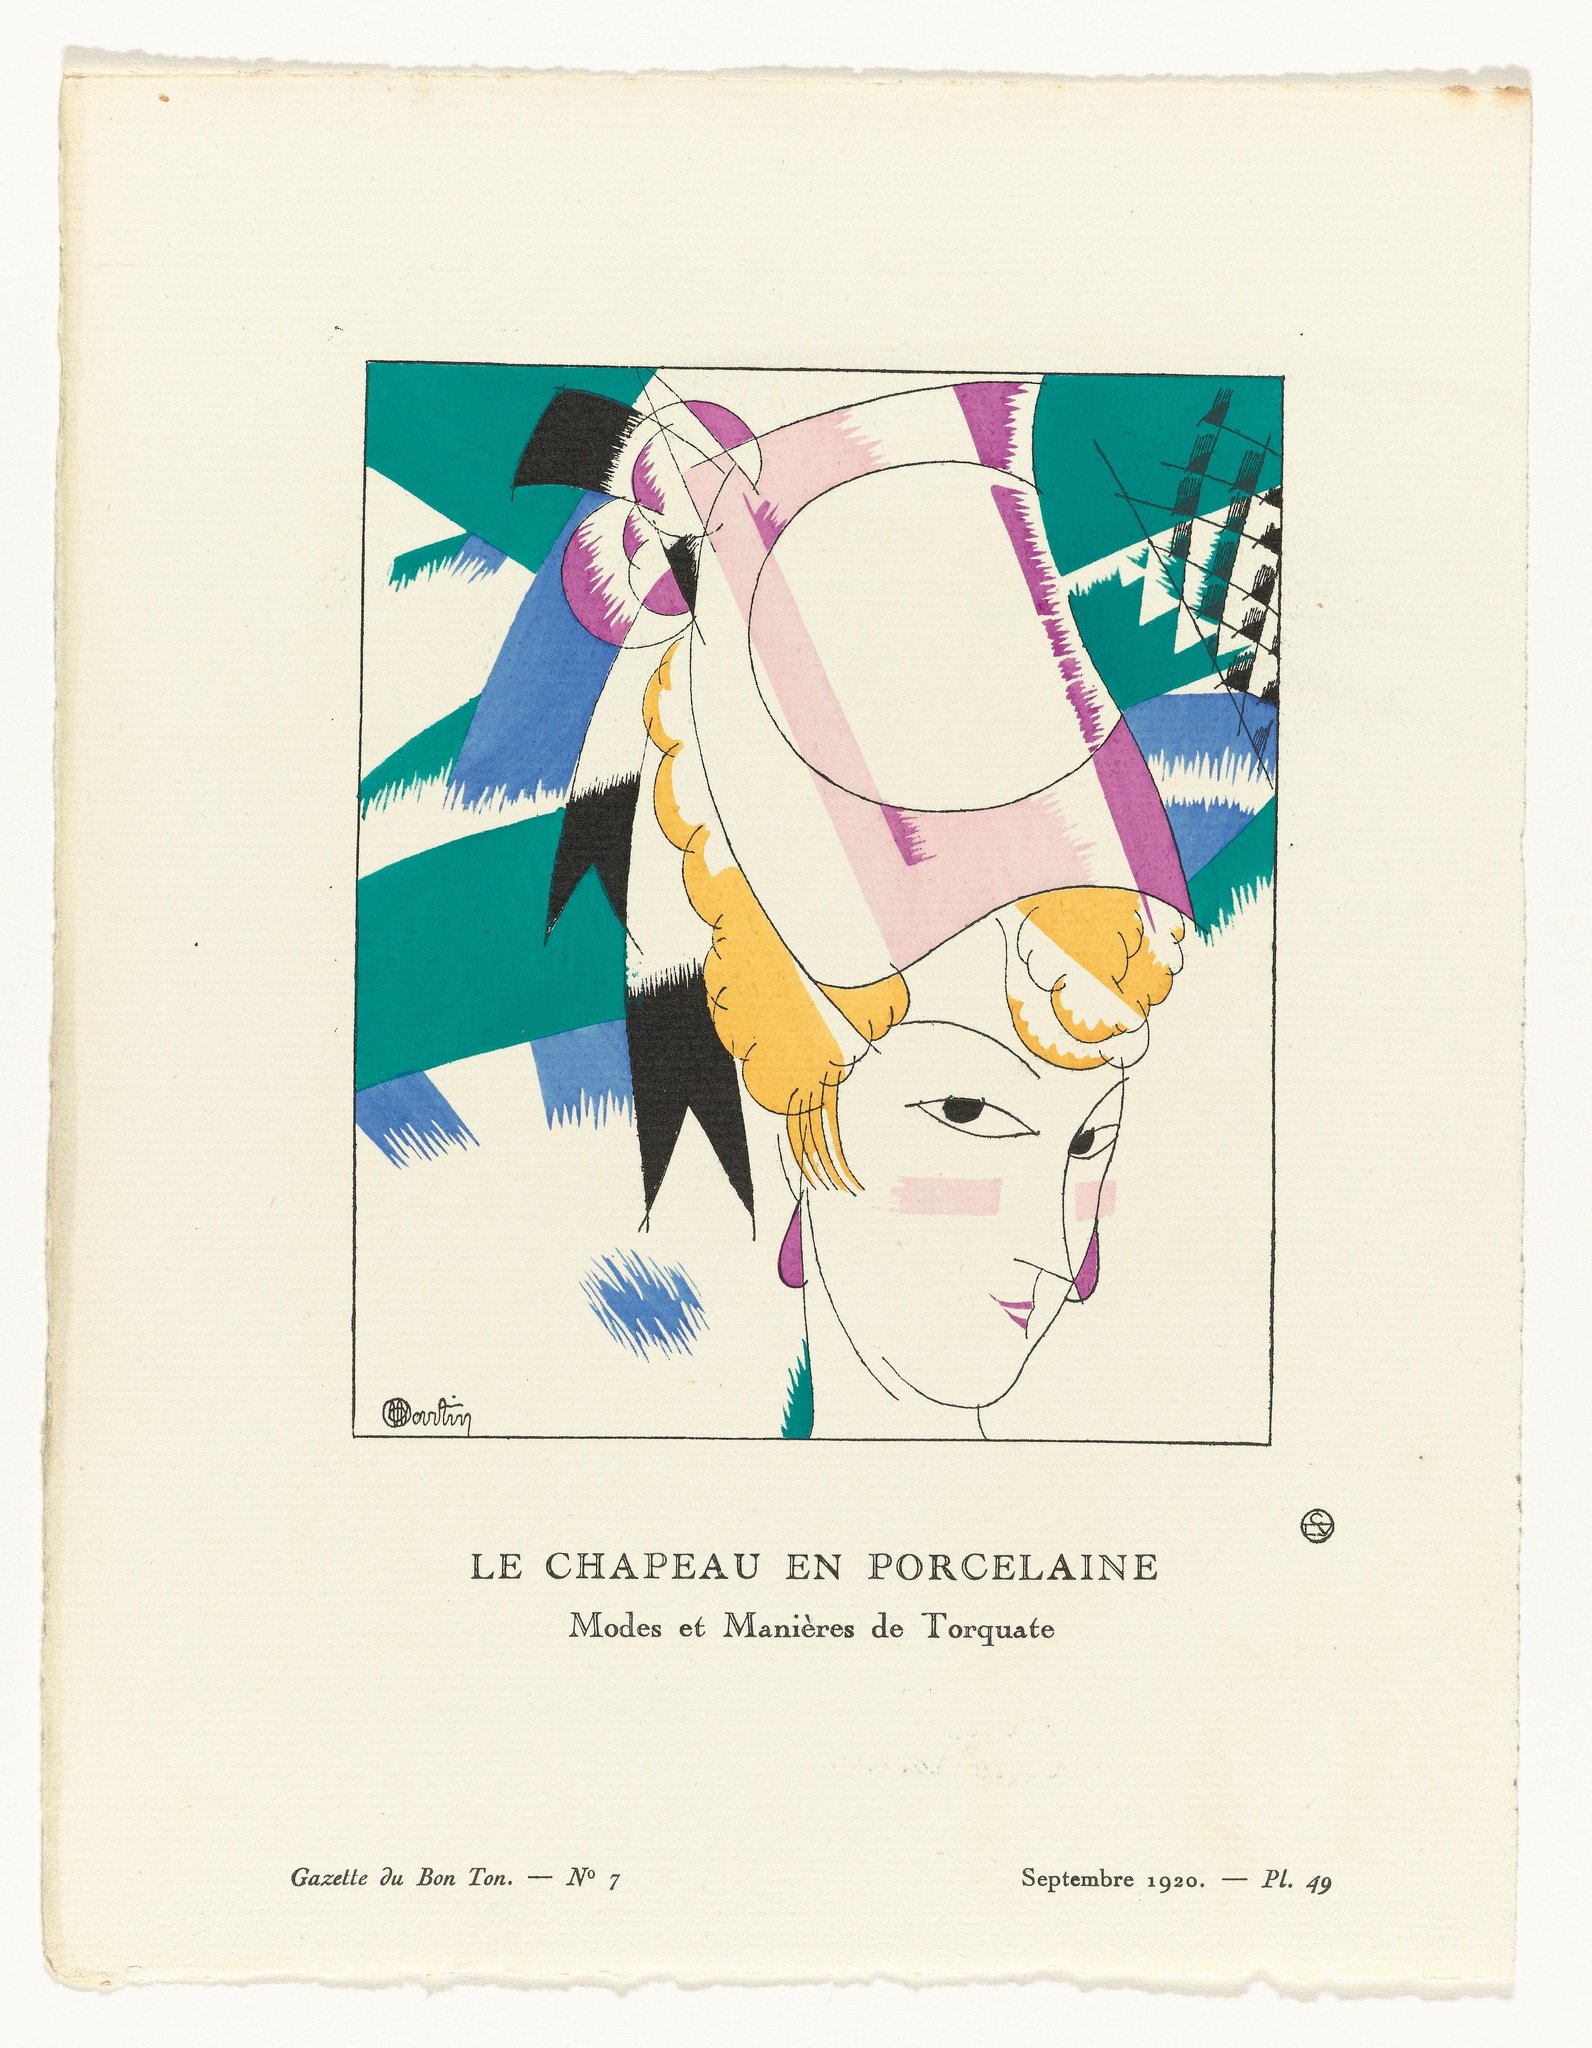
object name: fashion print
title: Gazette du Bon Ton, 1920 - No. 7, Pl. 49: Le chapeau en porcelaine / Modes et Manières de Torquate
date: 1920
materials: paper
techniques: hand coloring, letterpress printing, lithograph, pochoir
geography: paris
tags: ear-rings (+ women's clothes), head-gear (+ women's clothes), fashion plates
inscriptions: date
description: Vrouwenhoofd met hoed, versierd met lint. Paarse oorbellen. Planche 49 uit Gazette du Bon Ton 1920, No. 7. Uitleg over de hoed op pagina "Explication des Planches".